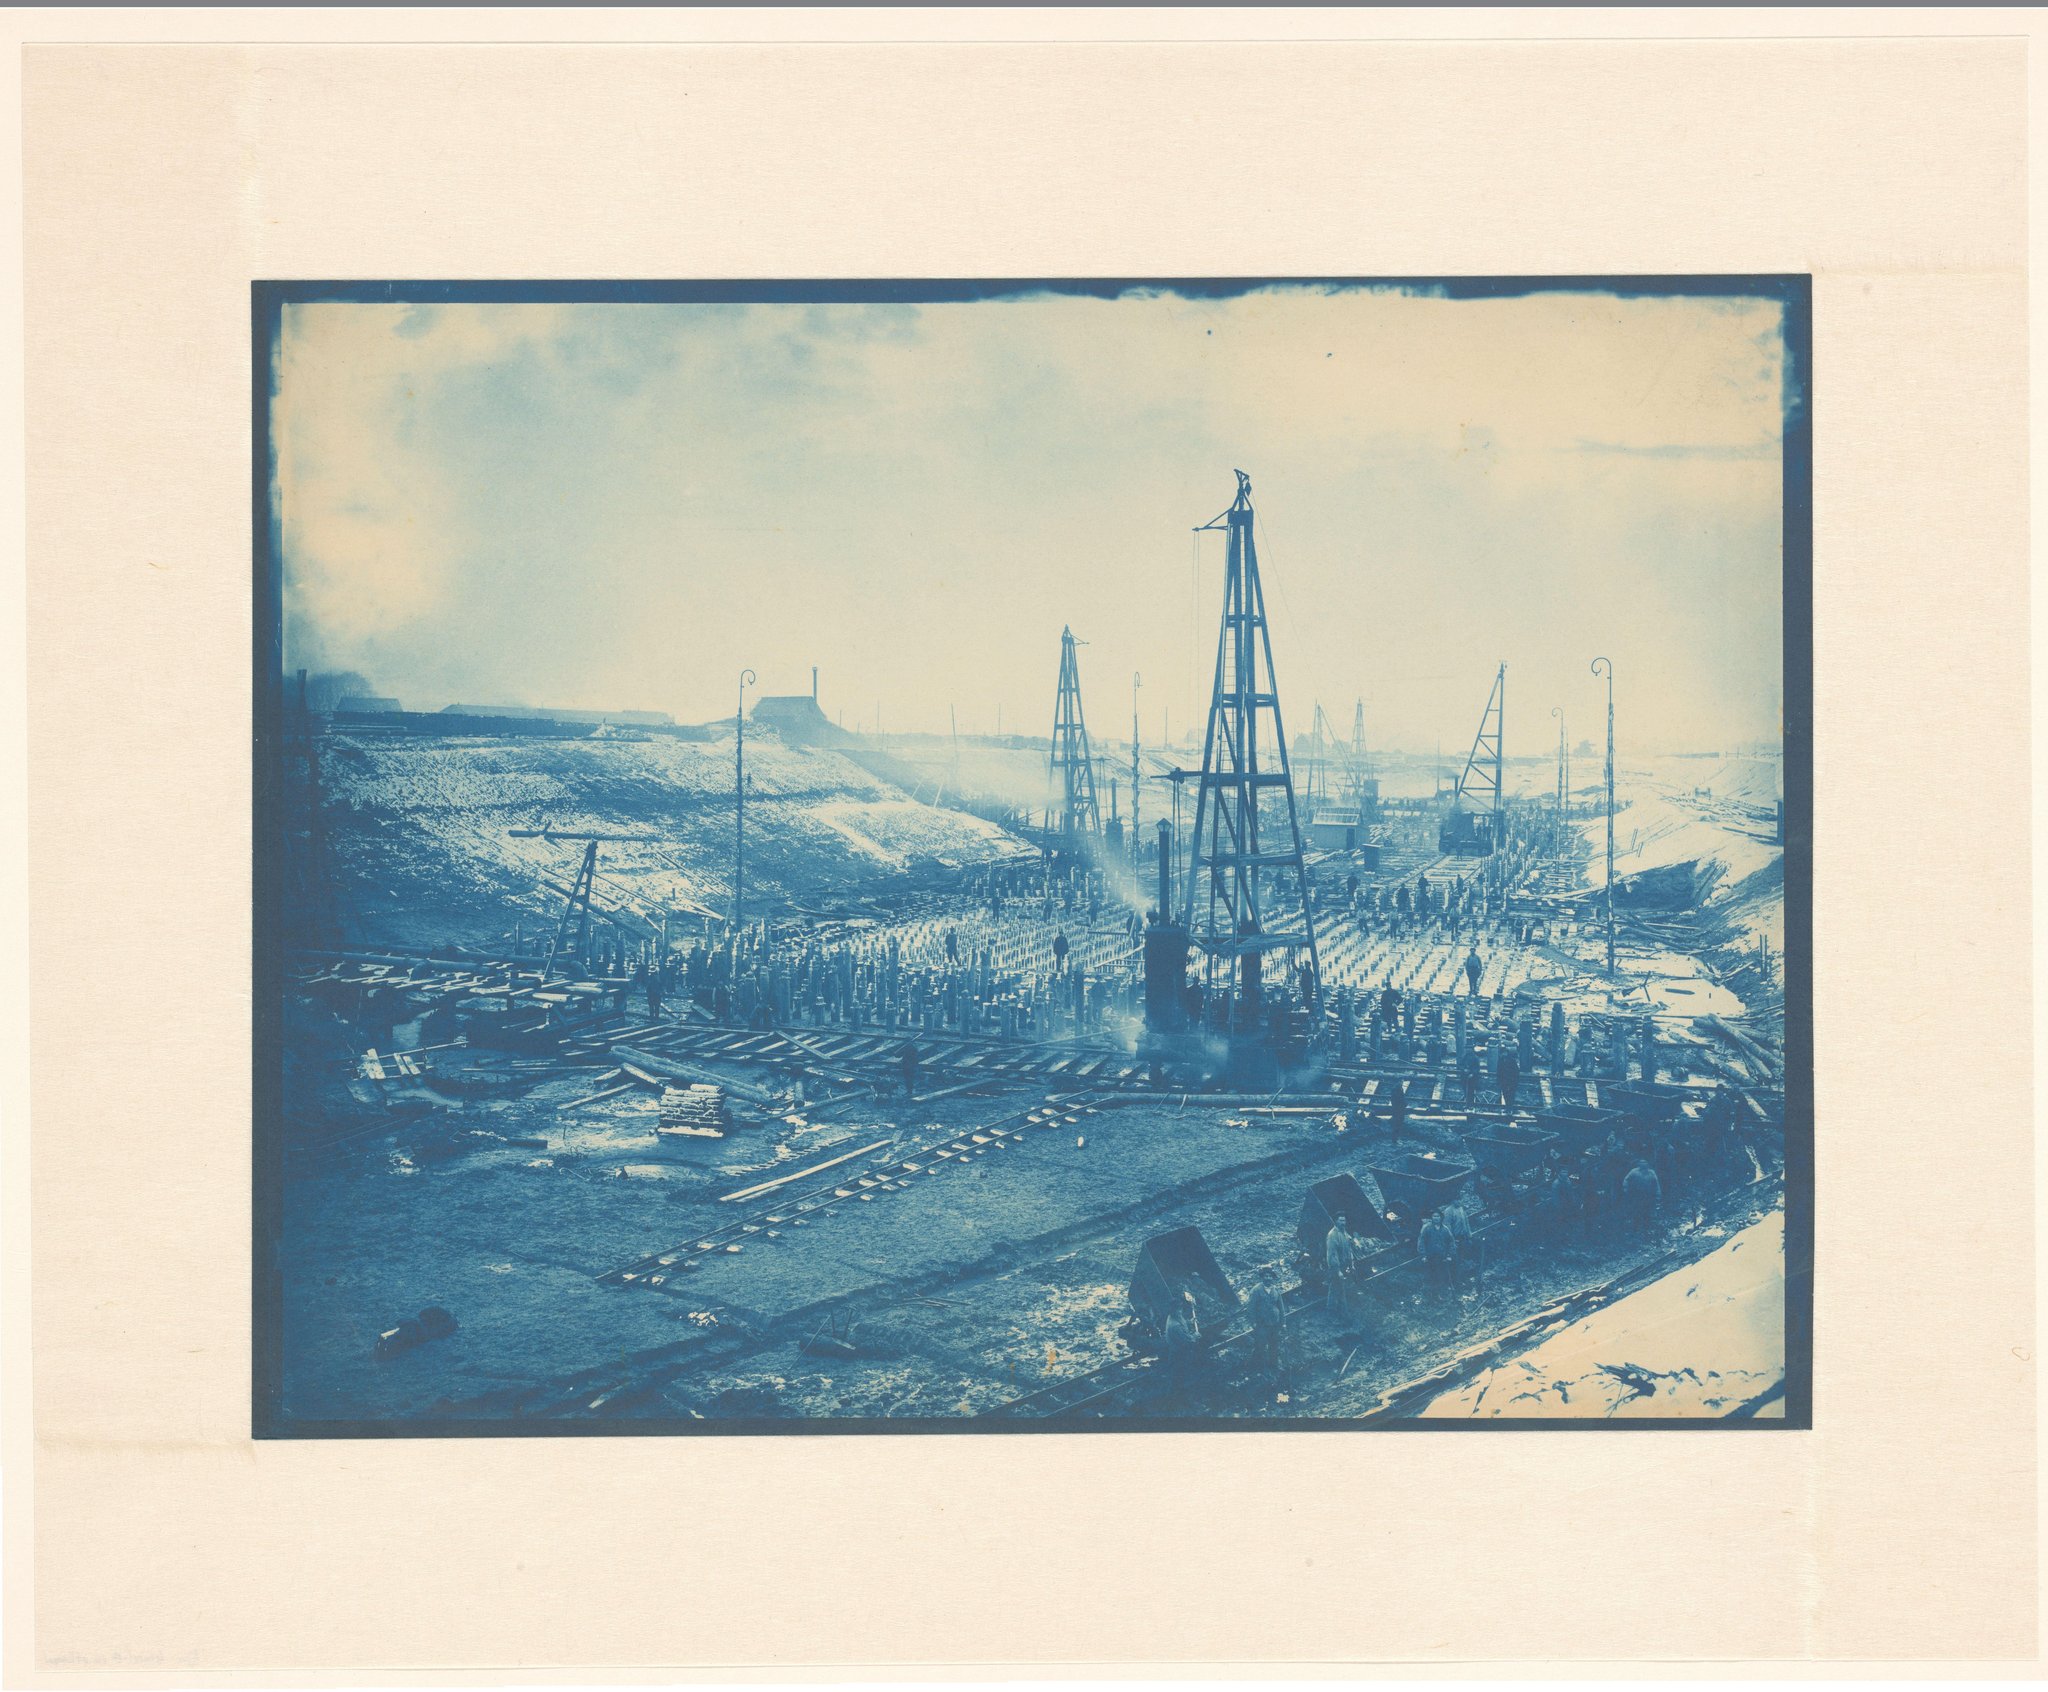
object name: photograph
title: Heiwerk voor de schutsluis ten westen van Terneuzen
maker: carl wilhelm bauer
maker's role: fotograaf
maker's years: 1844-1911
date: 1902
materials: photographic support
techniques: cyanotype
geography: terneuzen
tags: sluice, weir, building activities